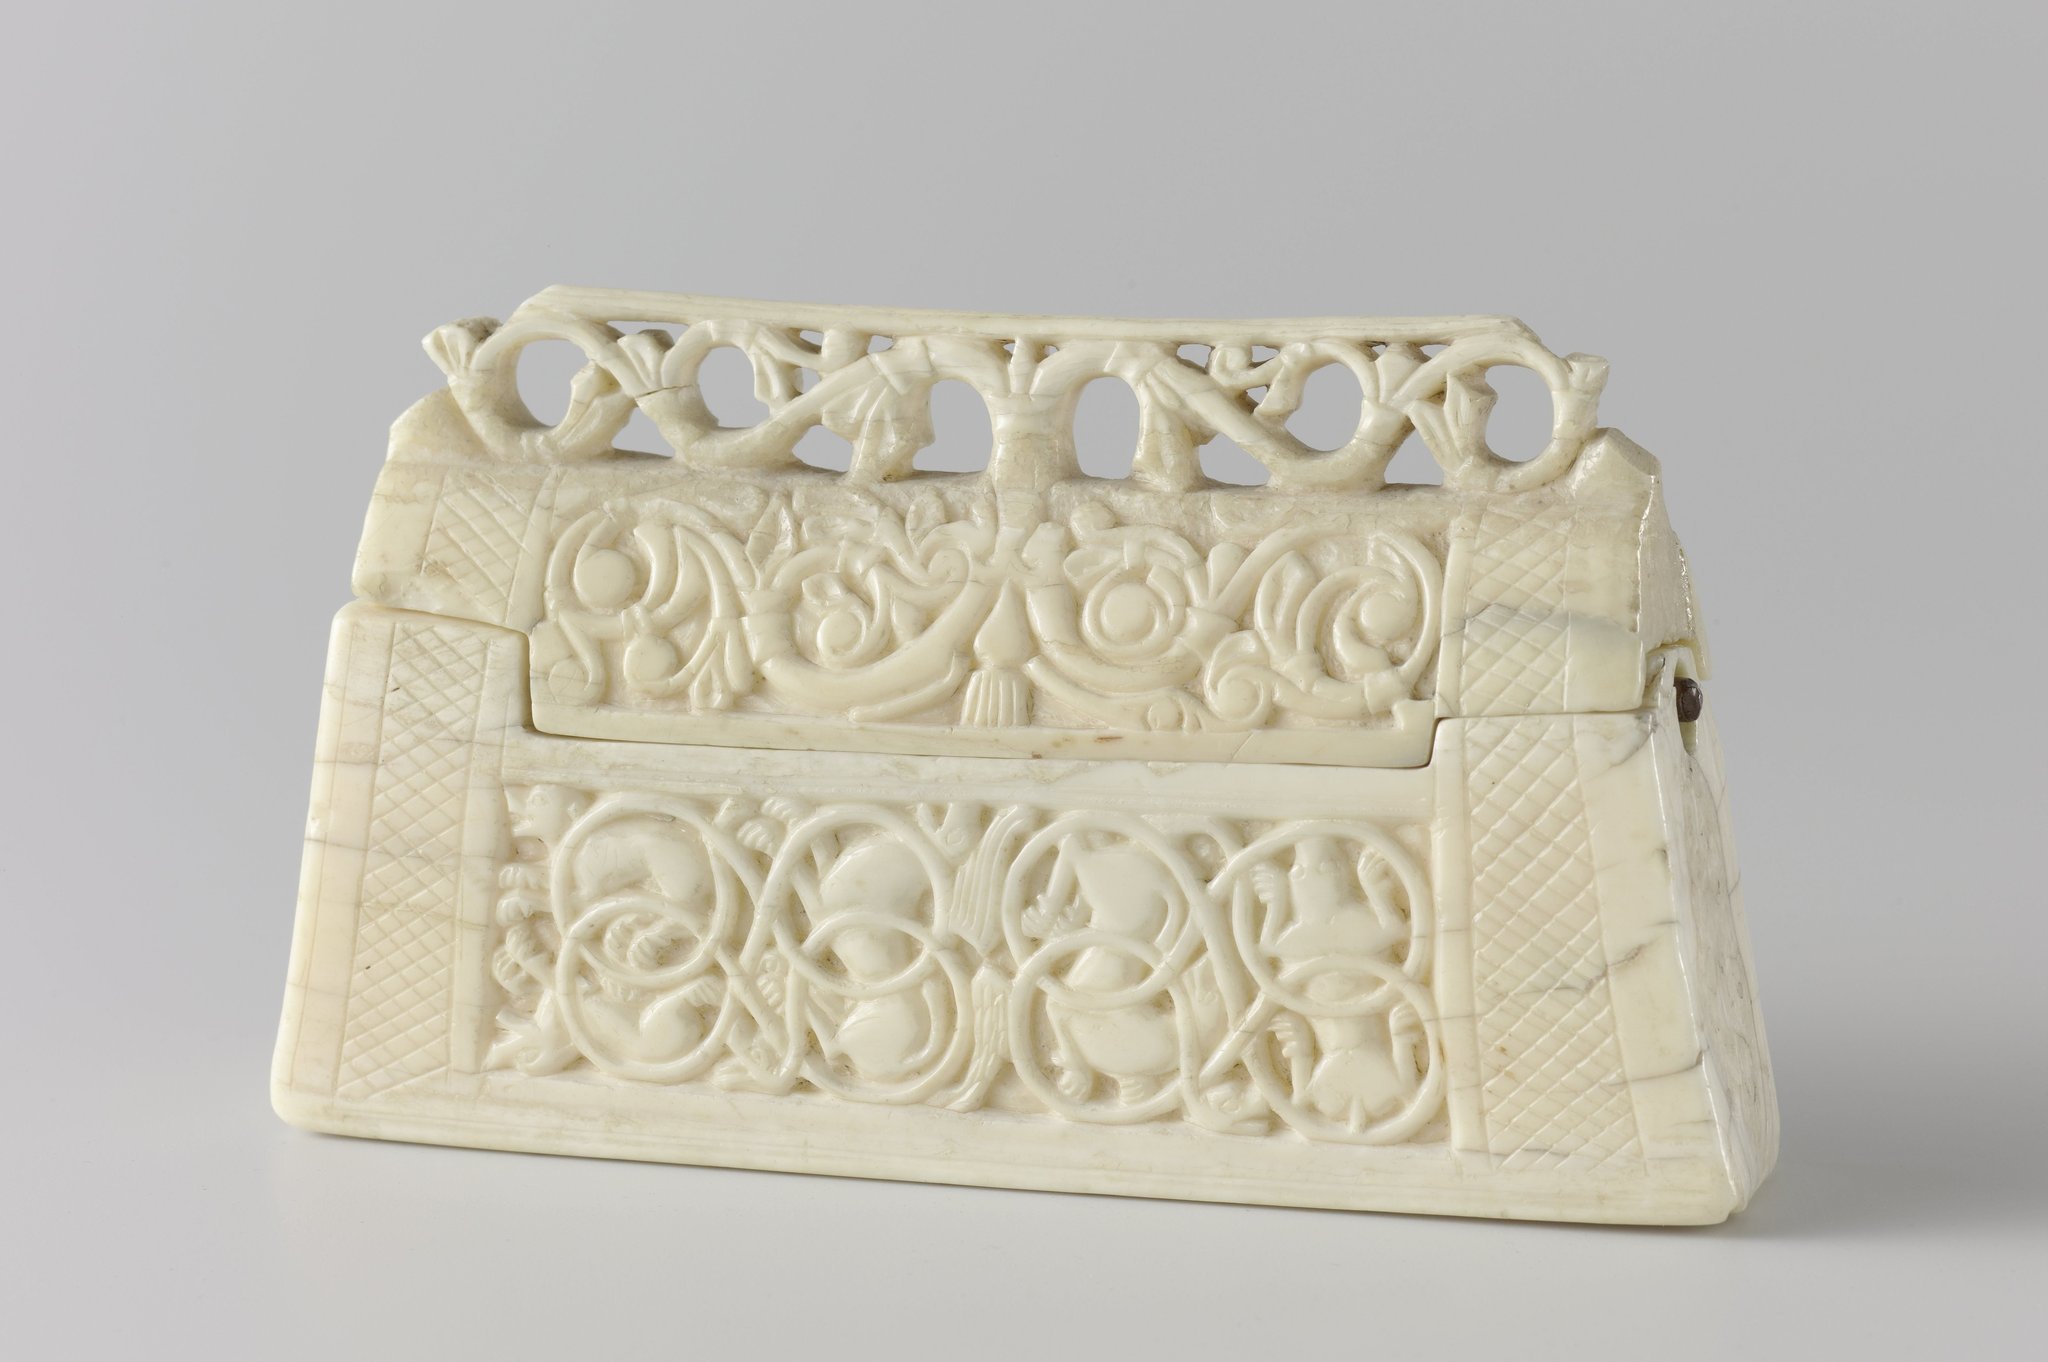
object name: box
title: Reliquary Holder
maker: Anonymous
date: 1125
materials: ivory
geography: norway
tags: ornament derived from animal forms, fabulous animals (sometimes wrongly called 'grotesques'); 'mostri' (ripa), animal interlace ~ ornament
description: De tapsvormige doos heeft aan beide zijden rechts en links een ruitvormige arcering, waartussen, in verdiept reliëf, viervoetige dieren achter een nagenoeg symmetrisch, cirkelvormig vlechtmotief van slangen, die op één zijde van de doos elk een vleugel hebben. Op het deksel zijn aan één zijde gevleugelde fabeldieren en aan de andere een motief van ranken aangebracht. Het handvat bestaat uit een opengewerkt rankenmotief. Het deksel zit door middel van een uittrekbare pen aan het onderstuk vast (object bestaat dus uit drie delen).